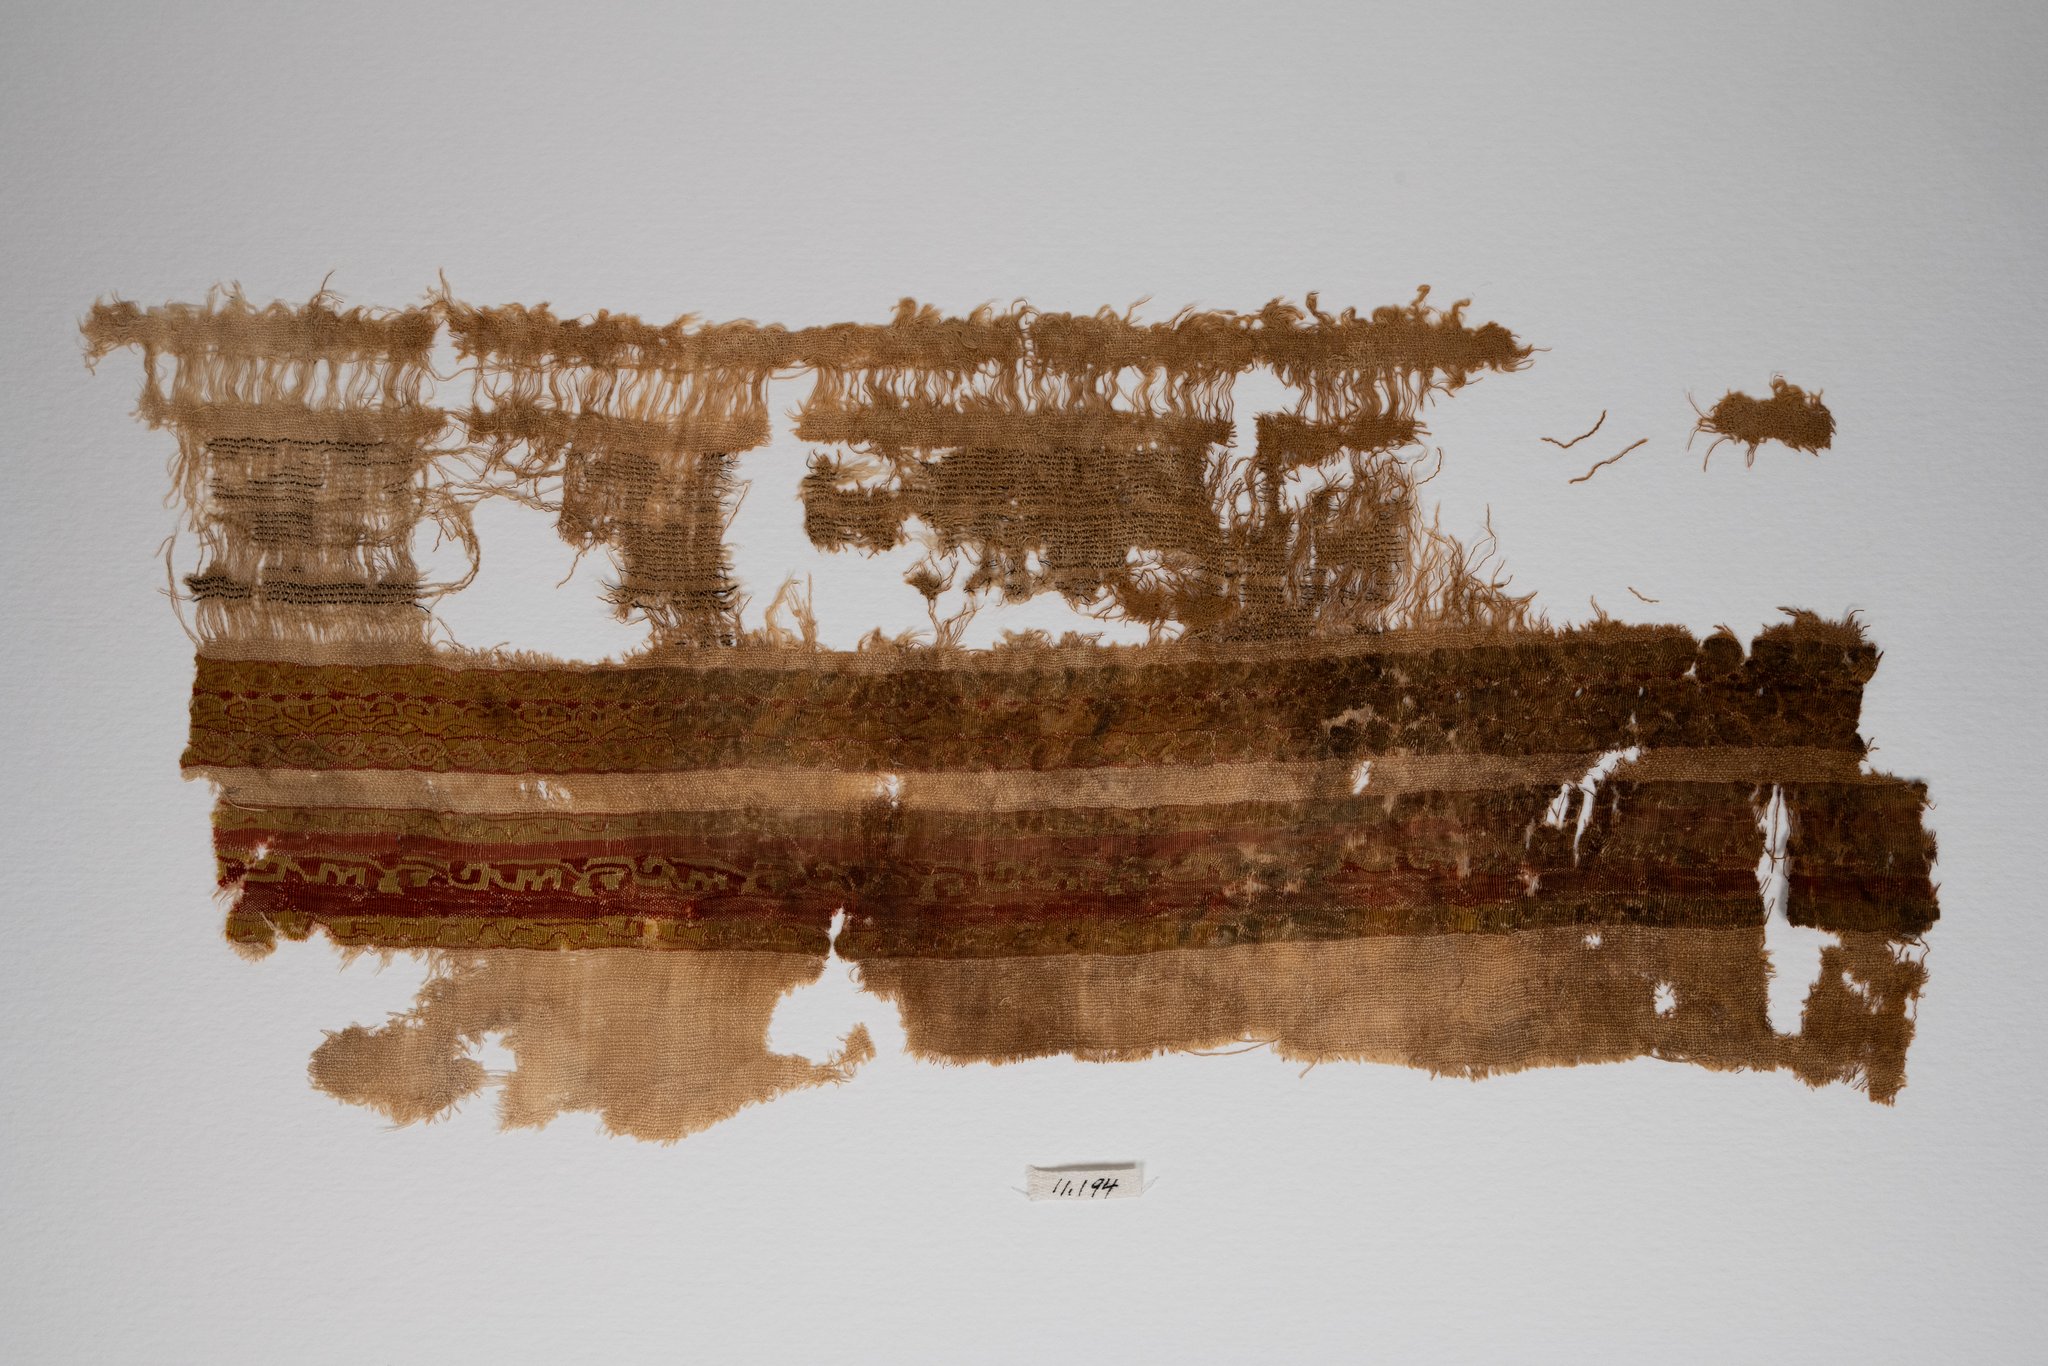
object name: textile fragment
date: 1101-1200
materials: silk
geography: egypt